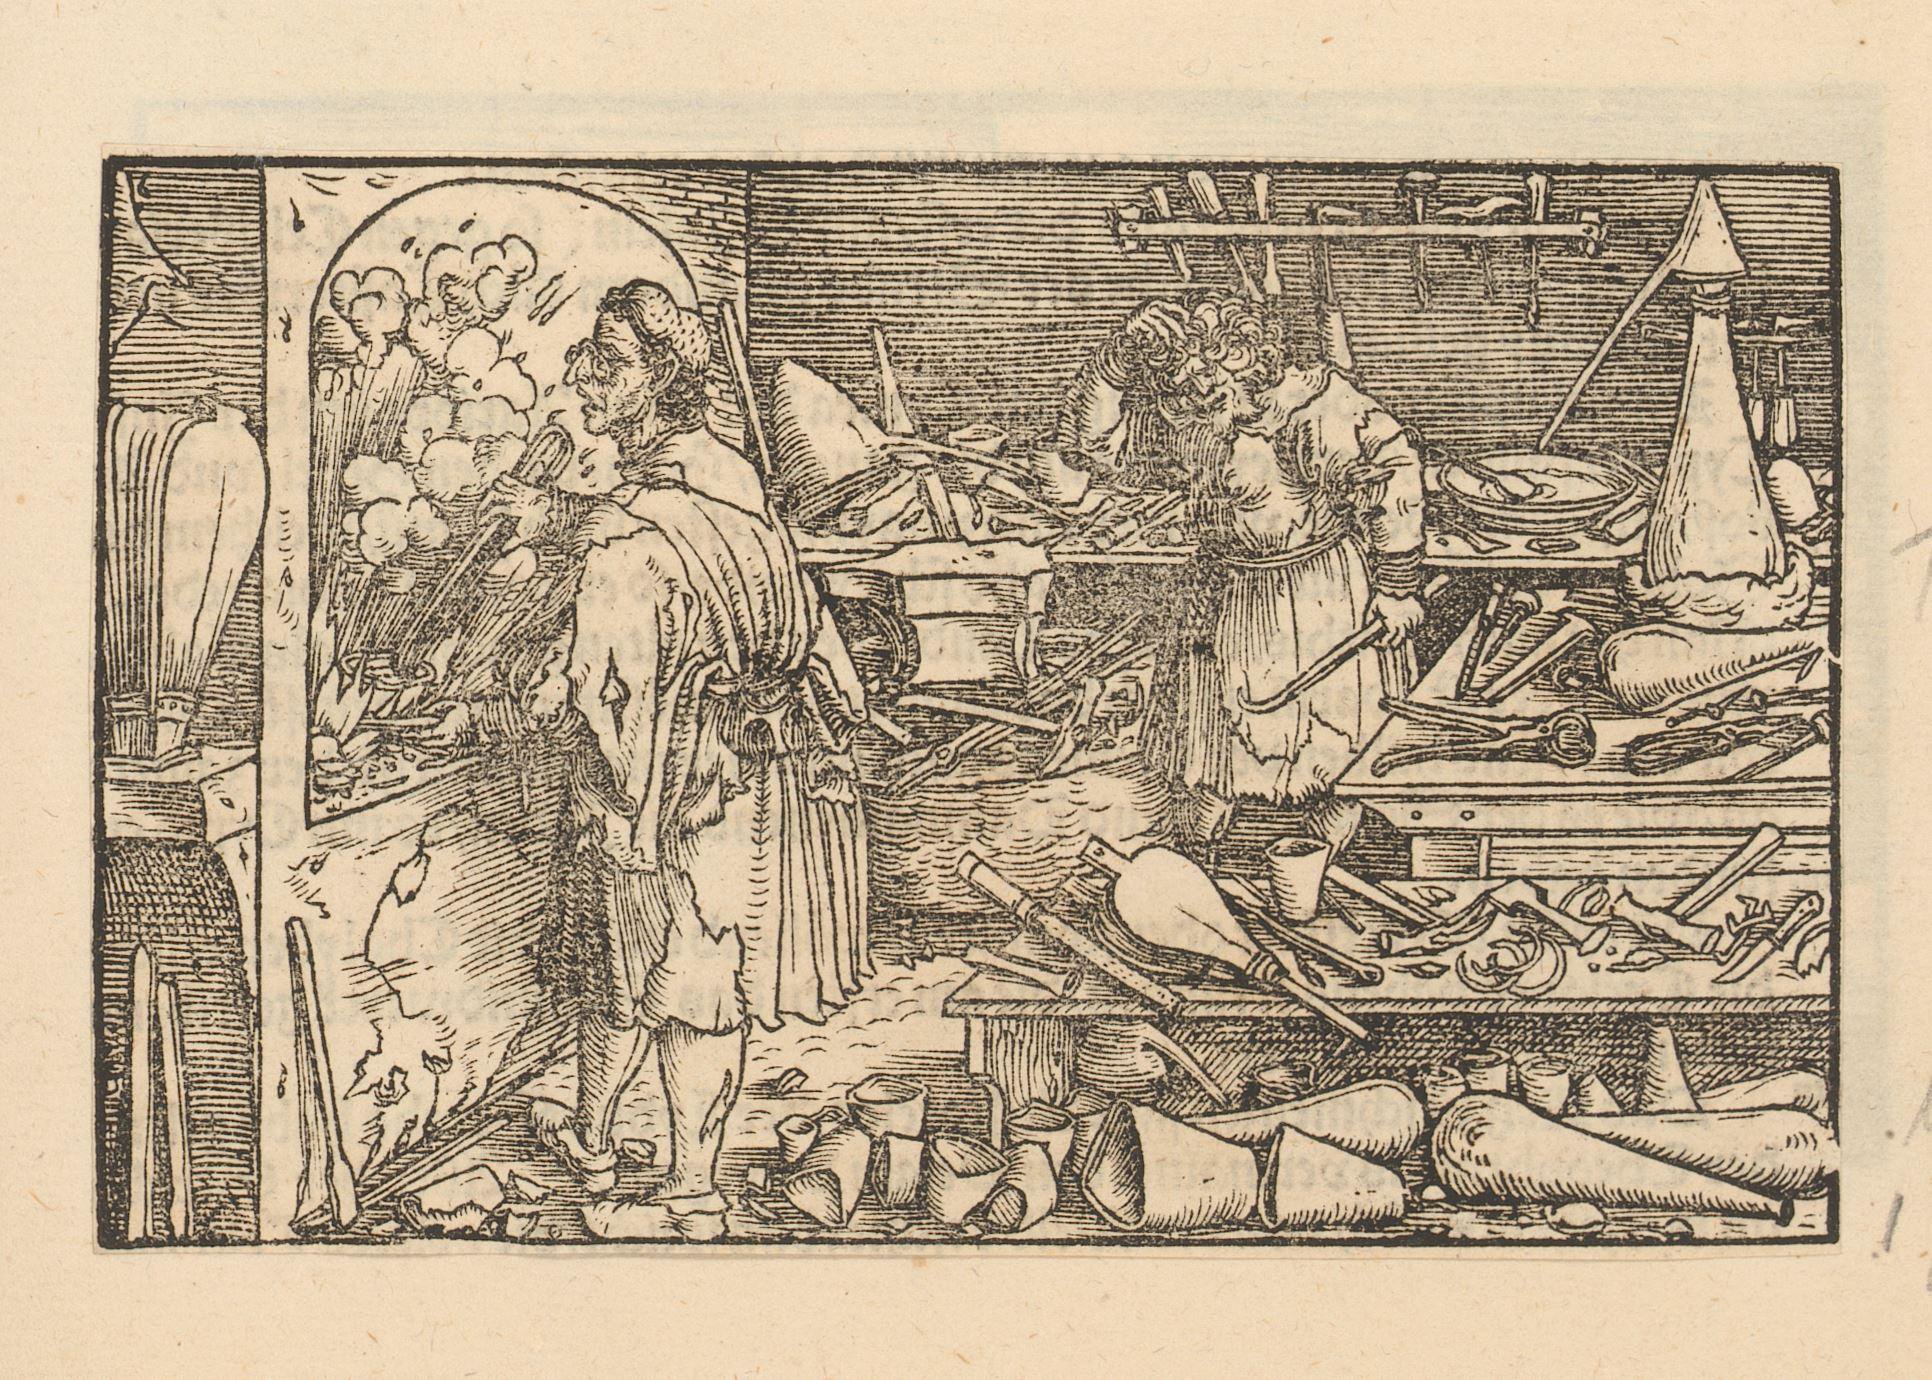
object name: album leaf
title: Twee alchemisten in hun werkplaats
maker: Anonymous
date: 1514-1532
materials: paper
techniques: letterpress printing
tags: alchemist at work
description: Deze prent is gebruikt in: Petrarca, Francesco. Von der Artzney bayder Glück, des guten und widerwertigen: unnd weß sich ain yeder inn Gelück und Unglück halten sol (...). Augsburg: Heinrich Steiner, 1532. Deze uitgave is ook bekend onder de titel 'Trostspiegel in Glück und Unglück'.